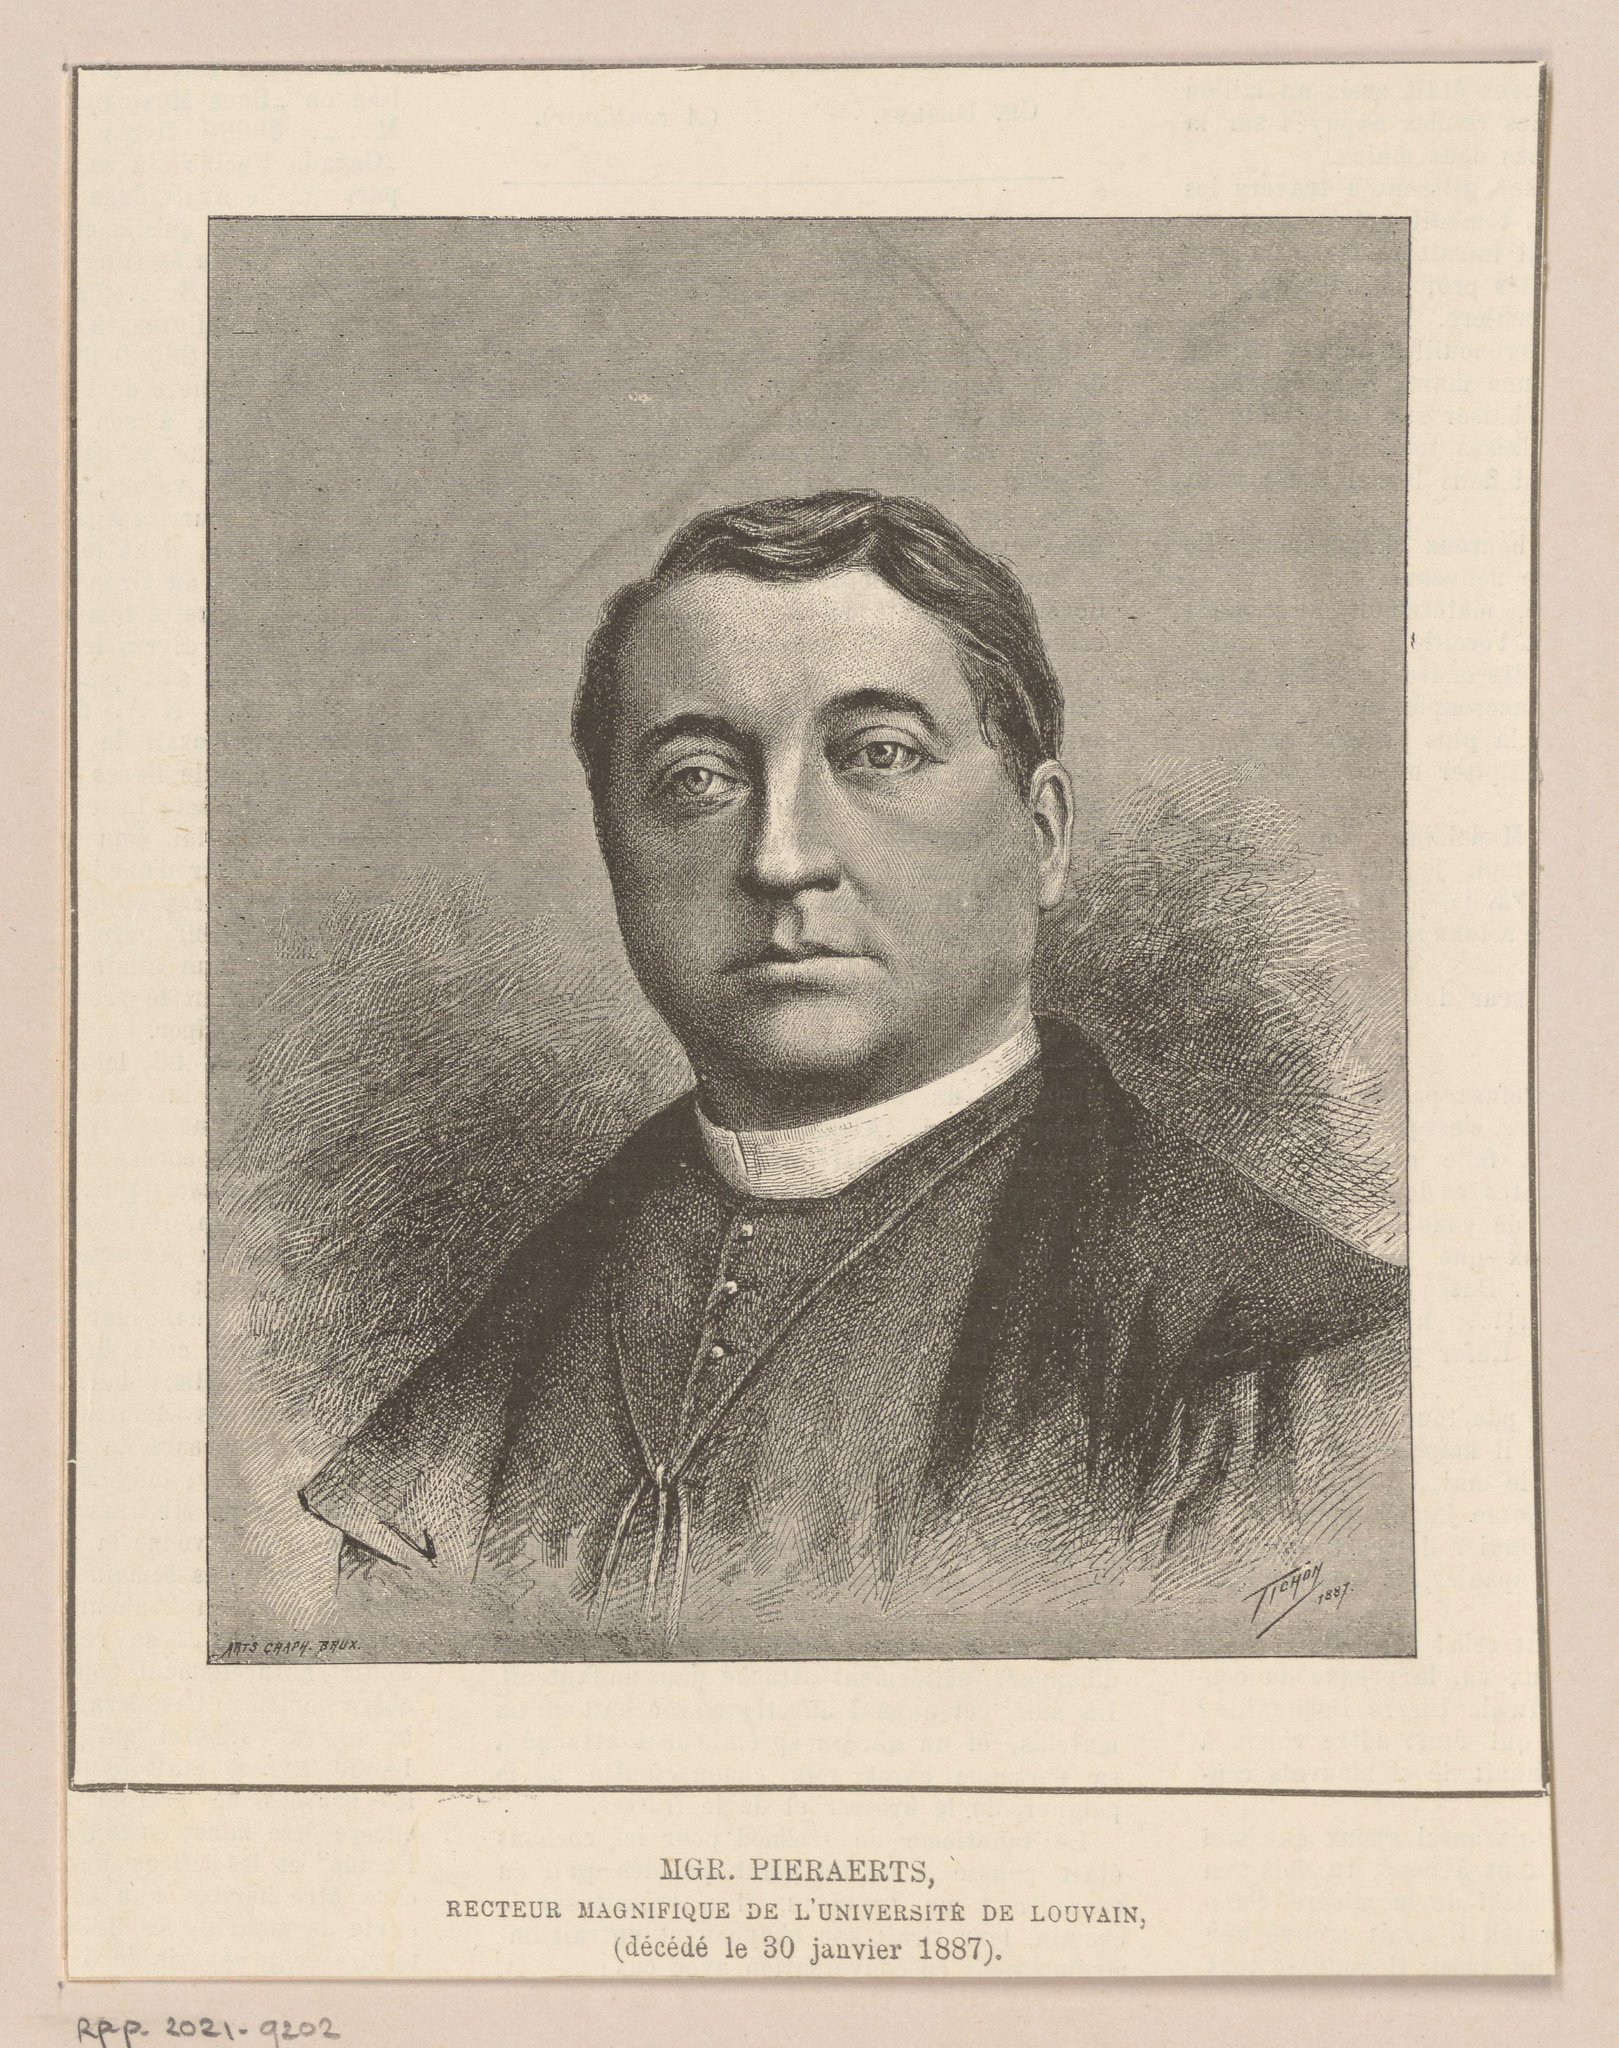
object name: print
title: Portret van Constant Pieraerts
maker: charles tichon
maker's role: draughtsman, painter, print maker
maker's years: 1865-1924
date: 1887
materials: paper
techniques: letterpress printing, engraving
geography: brussels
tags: adult man, historical persons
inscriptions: date